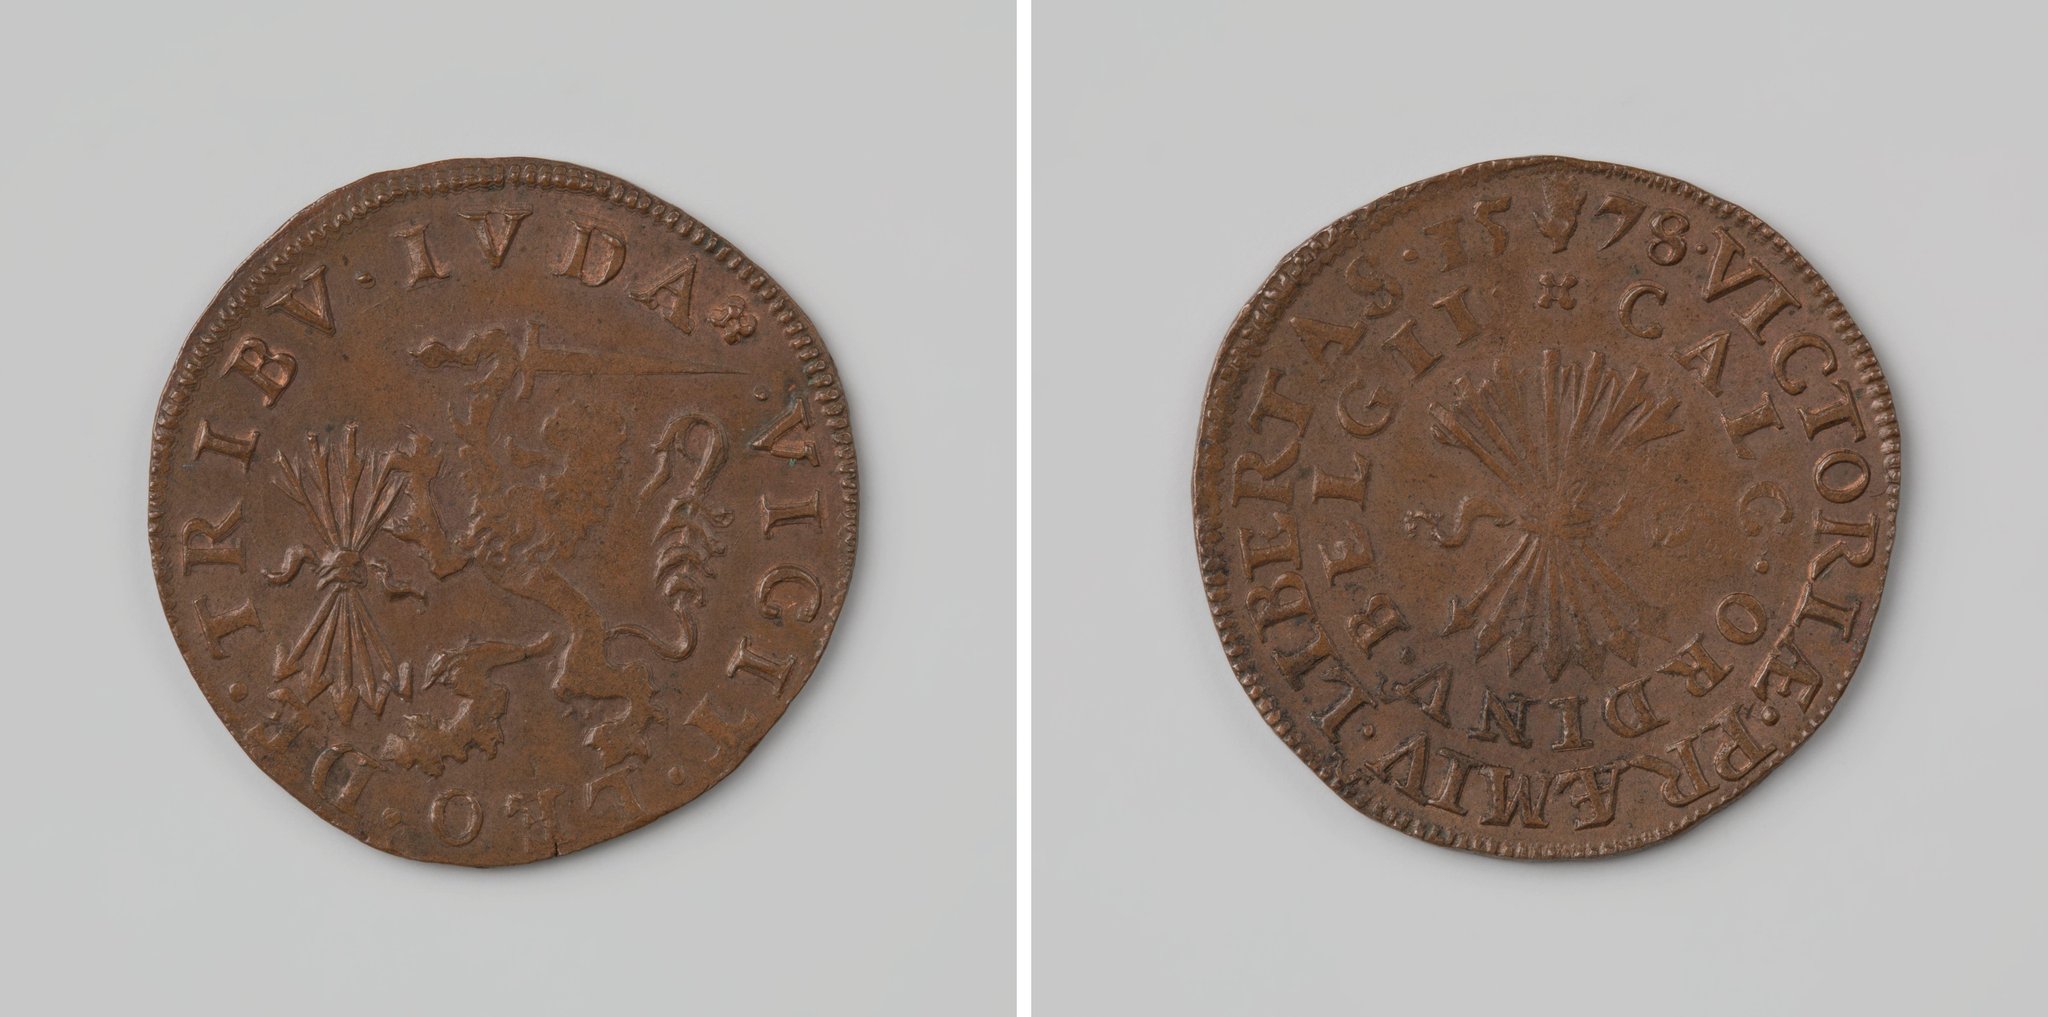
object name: jeton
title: Overwinning van de opstandelingen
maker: Anonymous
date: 1578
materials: copper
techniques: striking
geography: antwerp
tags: staten-generaal, tachtigjarige oorlog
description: Koperen penning. Voorzijde: leeuw met zwaard en bundel van vijf pijlen in klauwen binnen omschrift. Keerzijde: bundel van zeven pijlen binnen tweeregelig omschrift